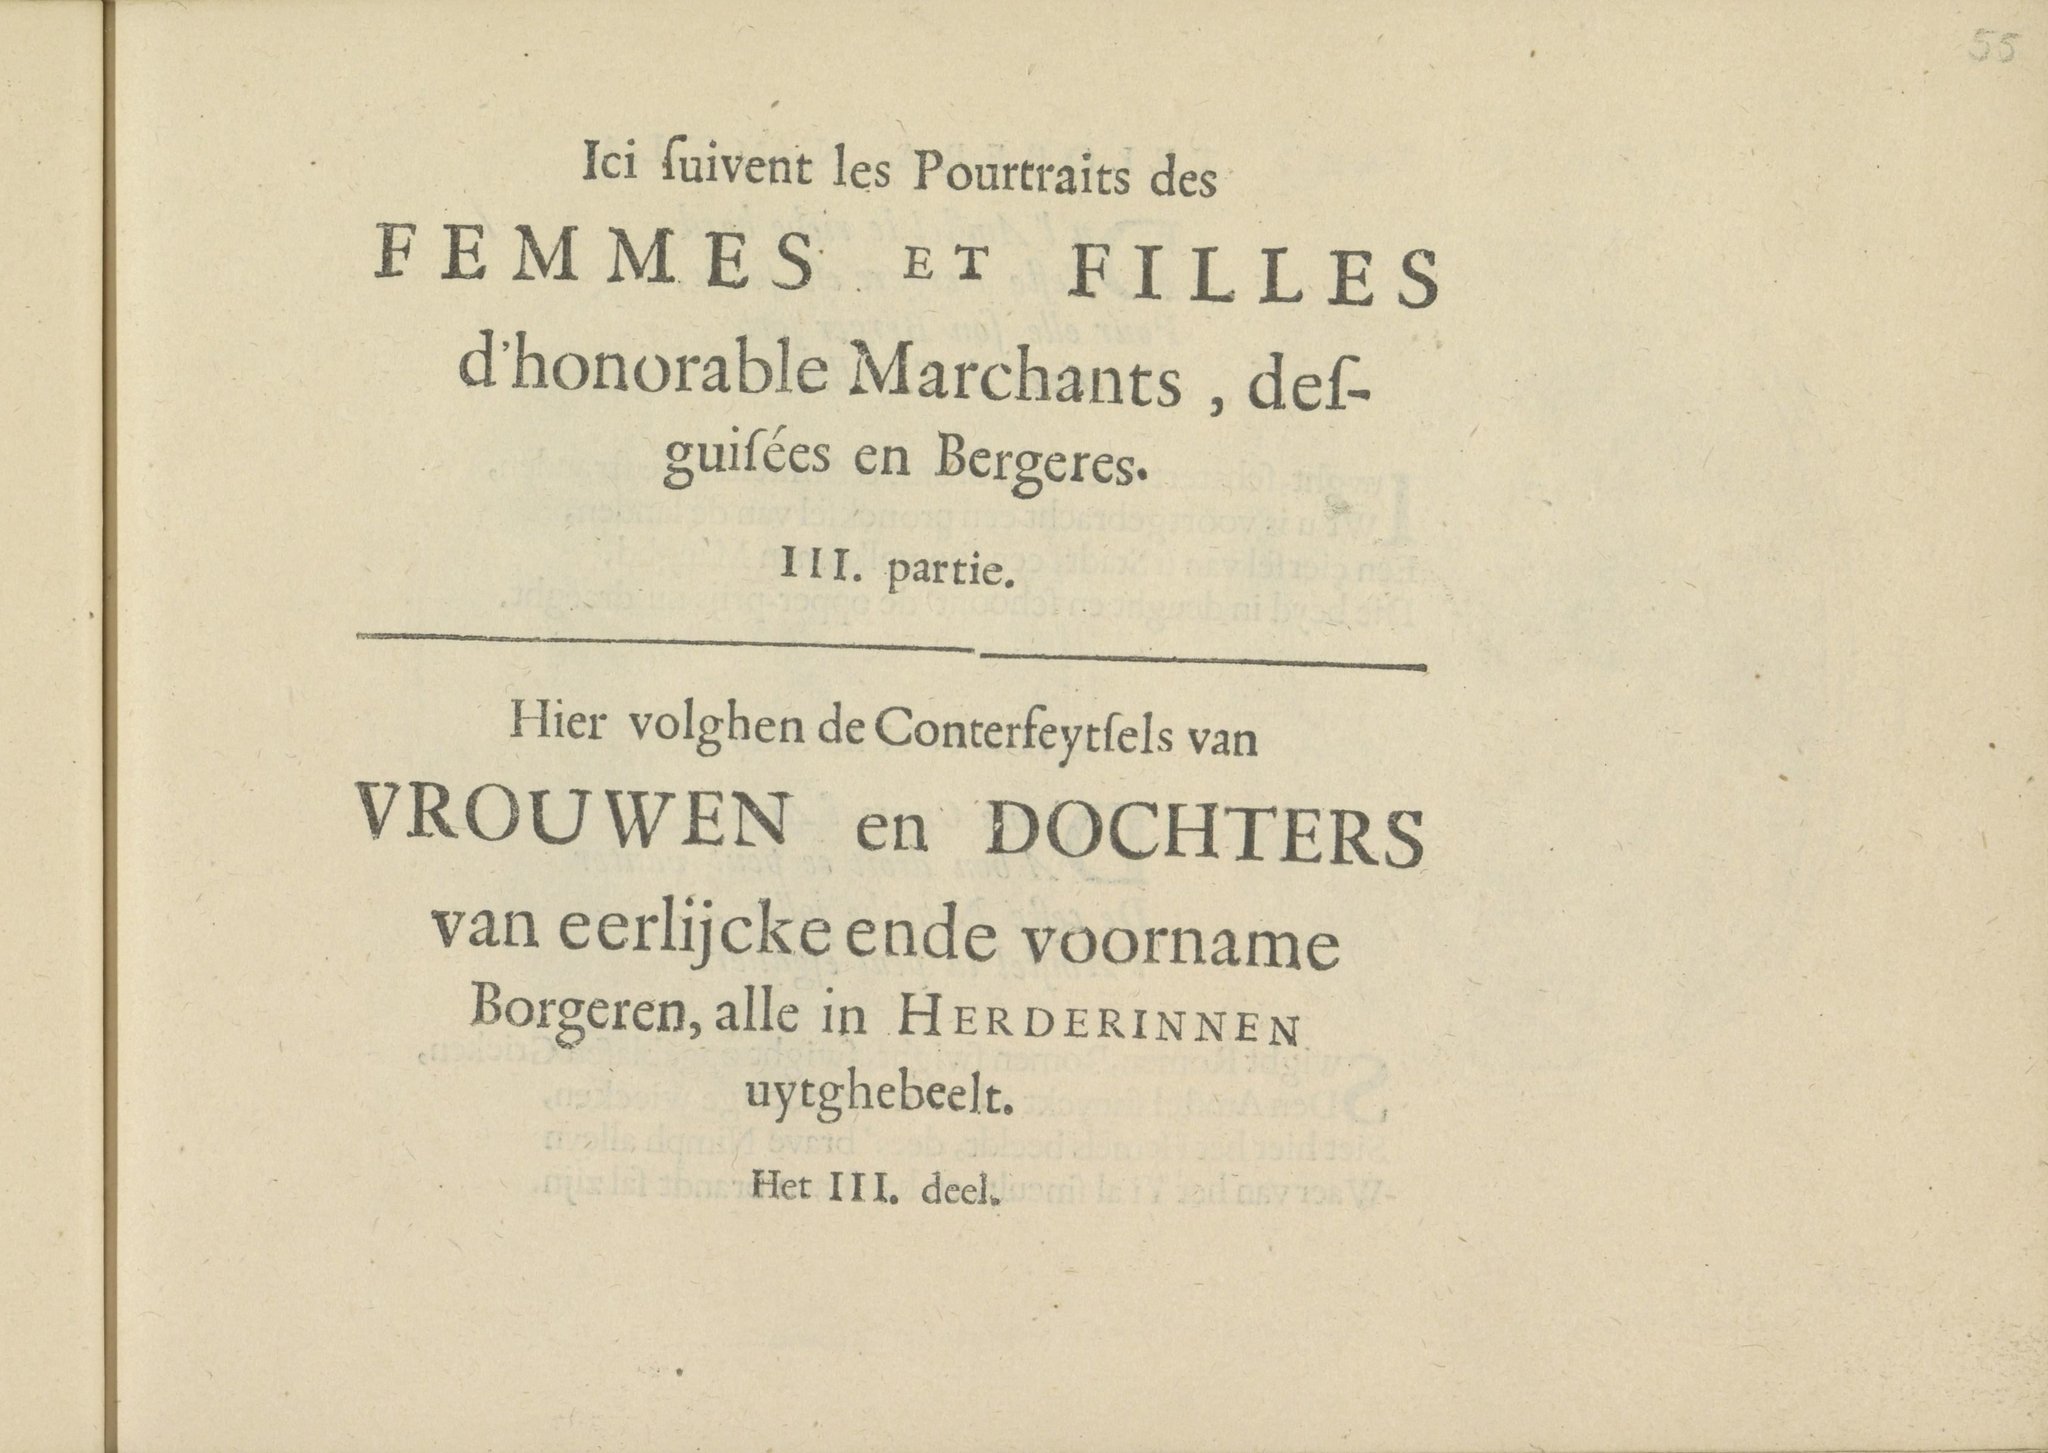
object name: album leaf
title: Les vrais pourtraits de quelques unes des plus grandes dames de la chrestiente desguisees en bergeres.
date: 1640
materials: paper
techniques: letterpress printing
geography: amsterdam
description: Titel voor het derde deel van de serie: Les vrais pourtraits ... Het blad maakt deel uit van een album.